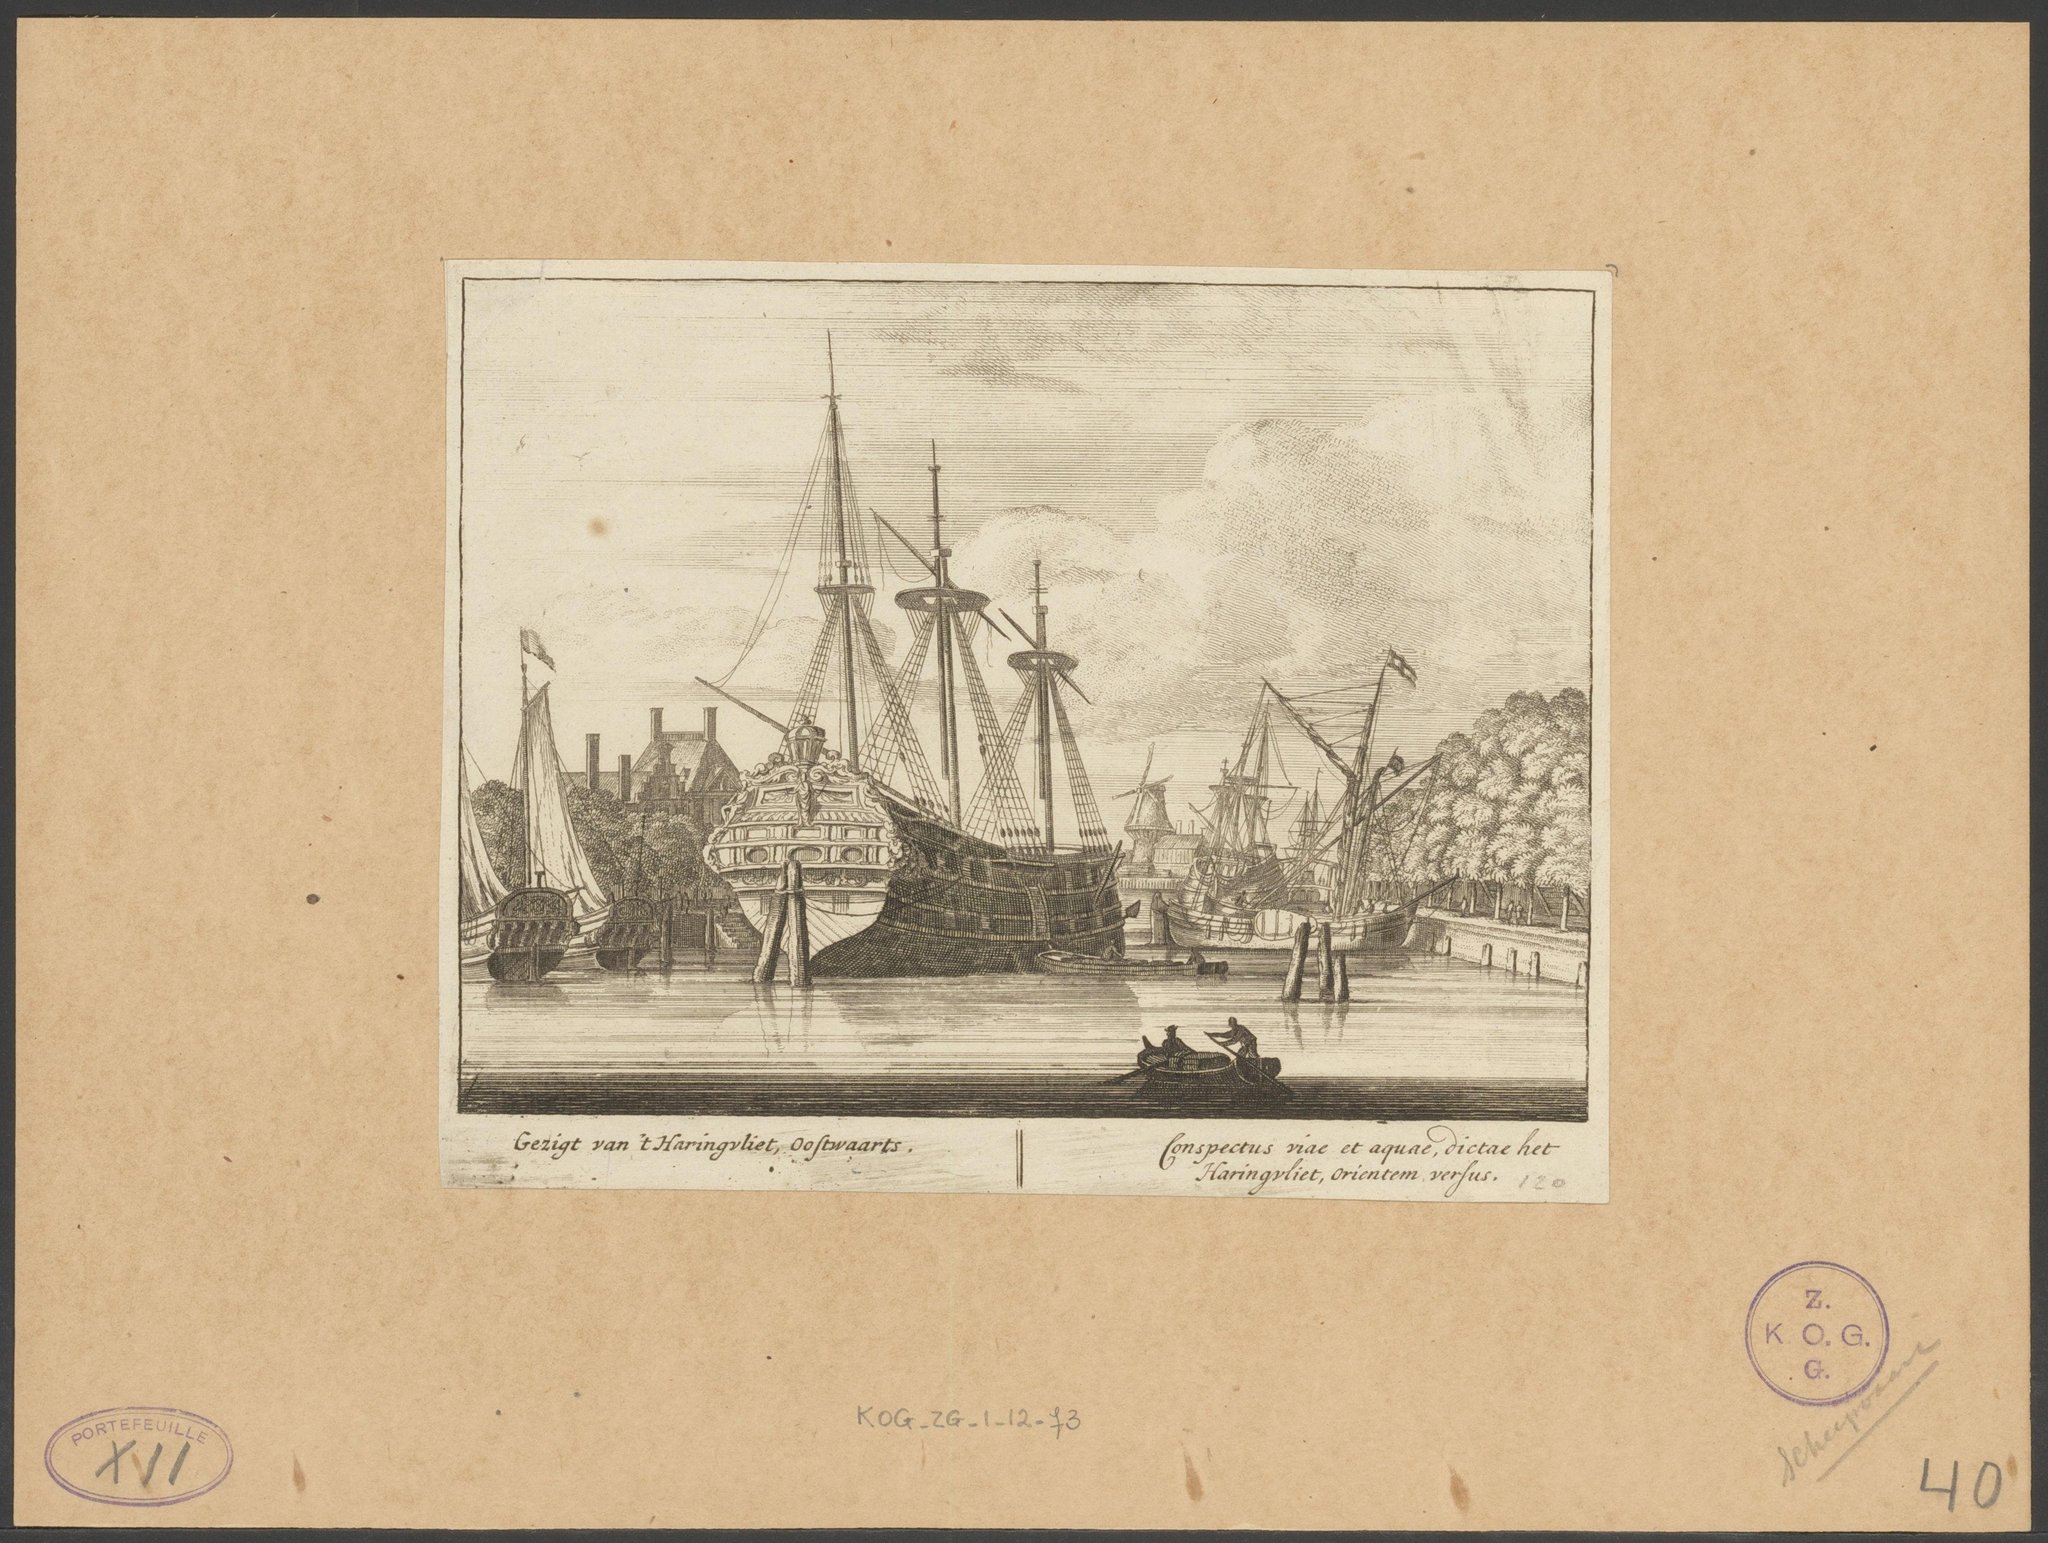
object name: print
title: Gezigt van 't Haringvliet, Oostwaarts / Conspectus viae et aquae, dictae het Haringvliet, Orientem versus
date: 1695-1711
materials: paper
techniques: etching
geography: amsterdam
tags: harbour, windmill in landscape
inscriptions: collector's mark: Lugt 1641, stamp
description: Onderwerpsrubrieken binnen de Atlas Zeden en Gewoonten: Handel, Nijverheid en Verkeer, Scheepsvaart.